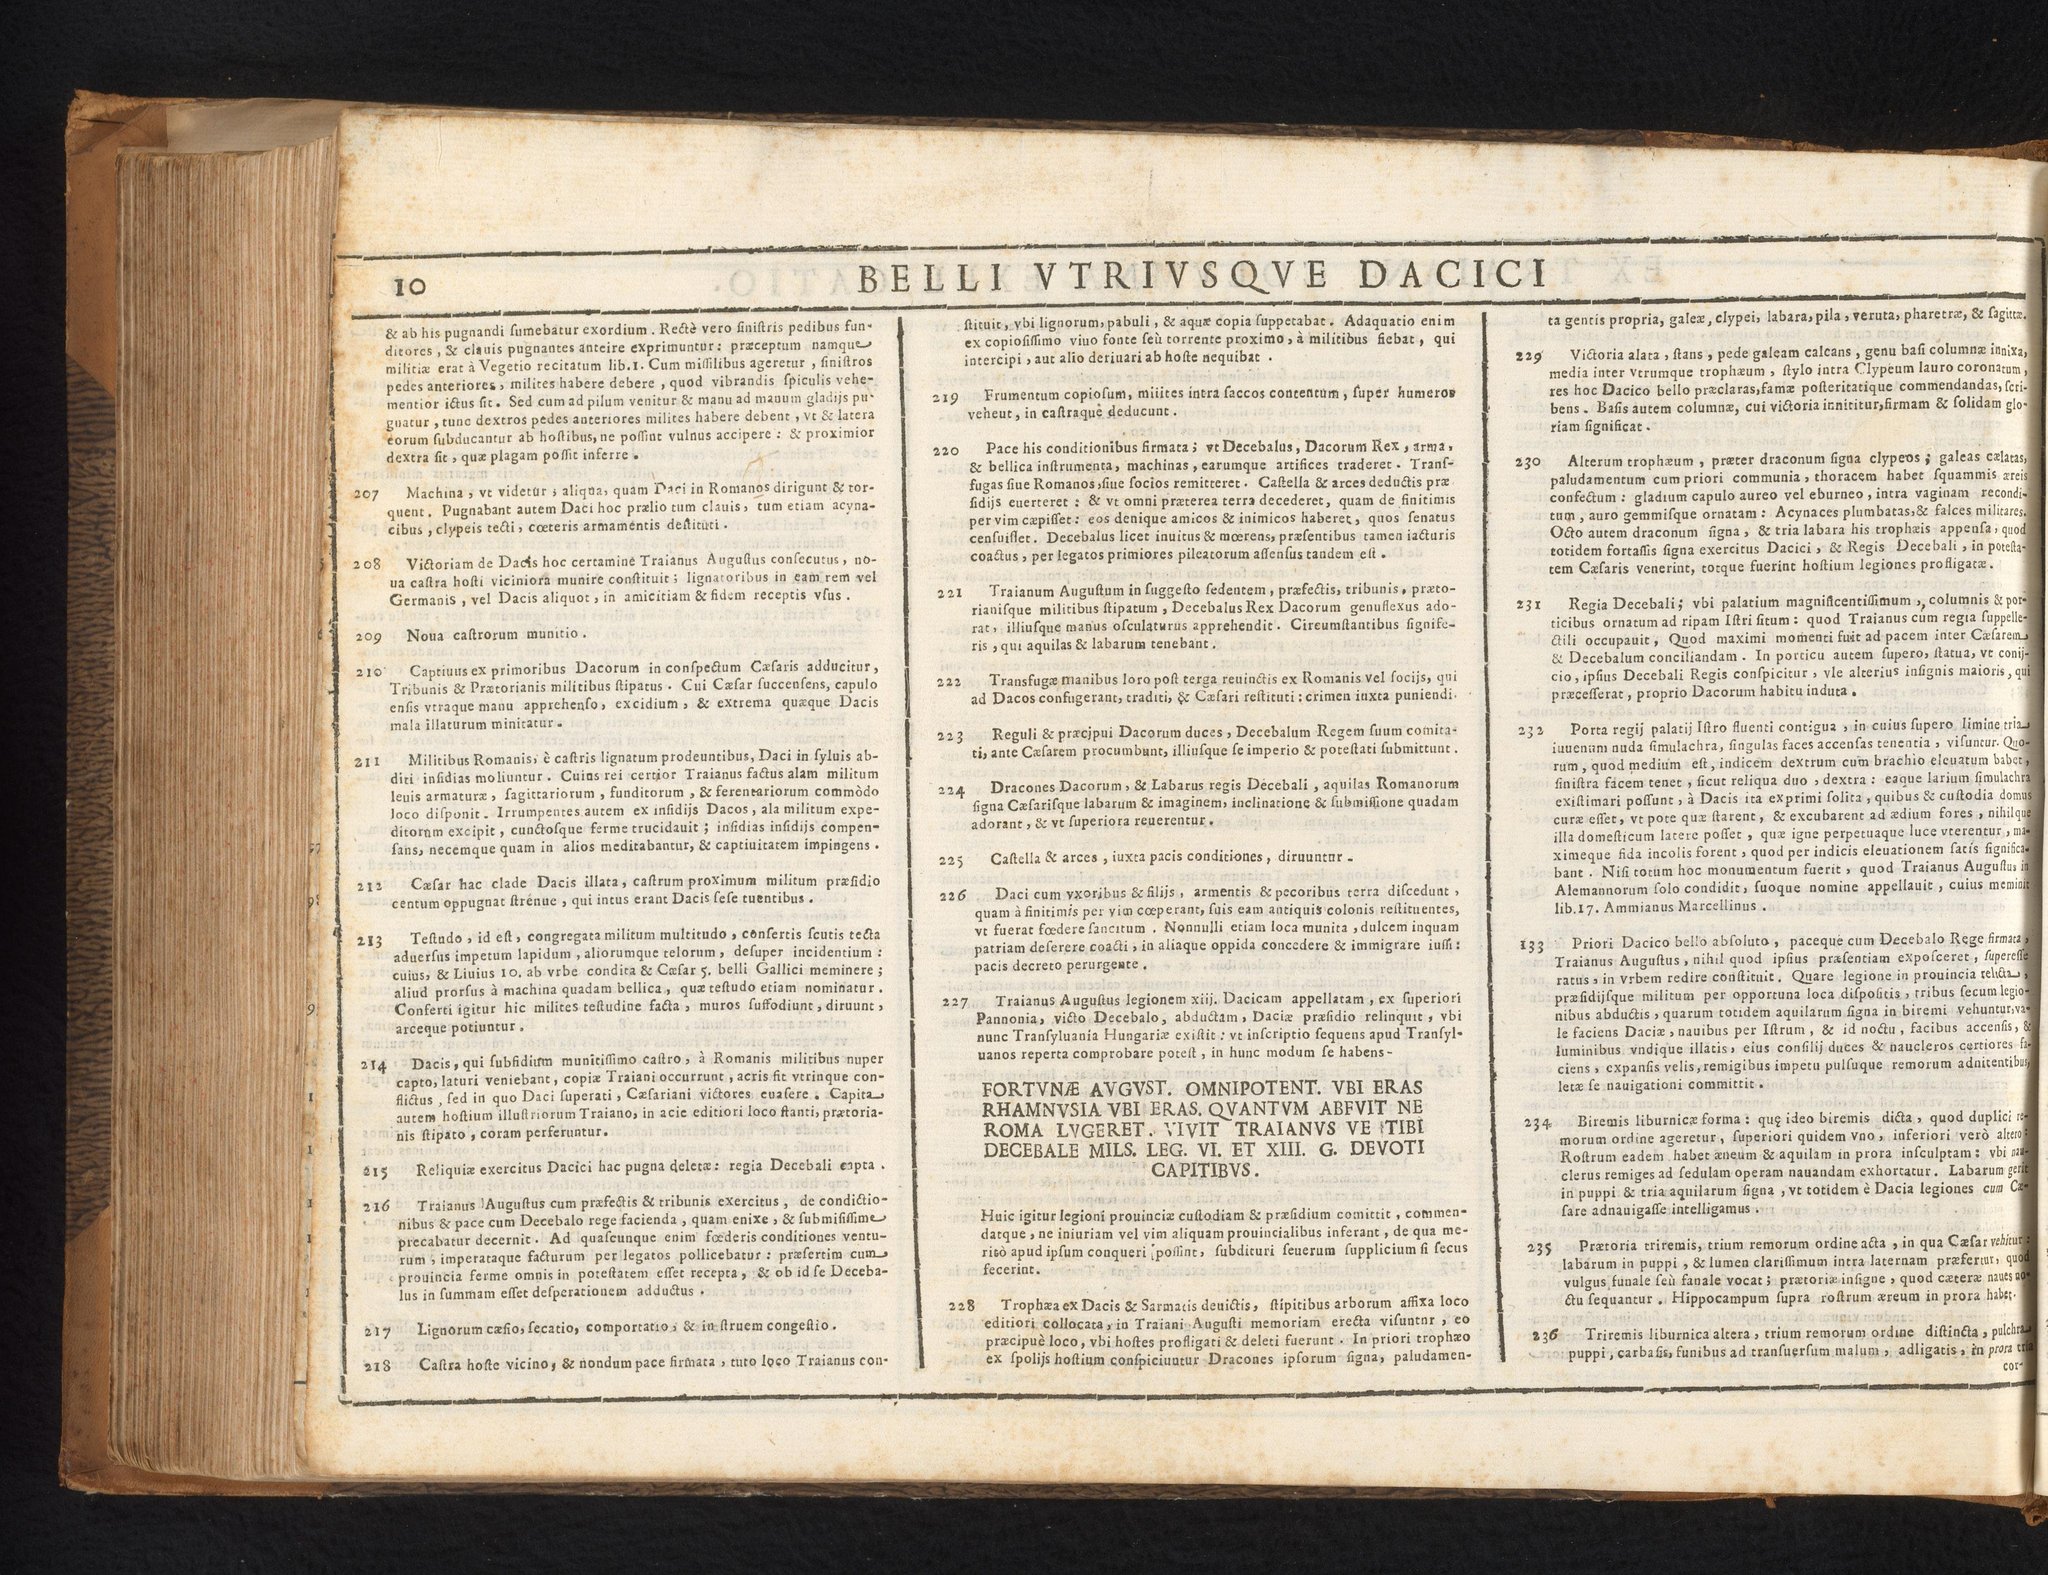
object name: album leaf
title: Historia utriusque belli dacici a Traiano Caesare gest (...)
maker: Anonymous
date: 1550-1599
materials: paper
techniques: letterpress printing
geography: rome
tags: zuil van trajanus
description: Een beschrijving van scènes 207 tot en met 236 op de Zuil van Trajanus, in het Italiaans. Prent maakt deel uit van een album.